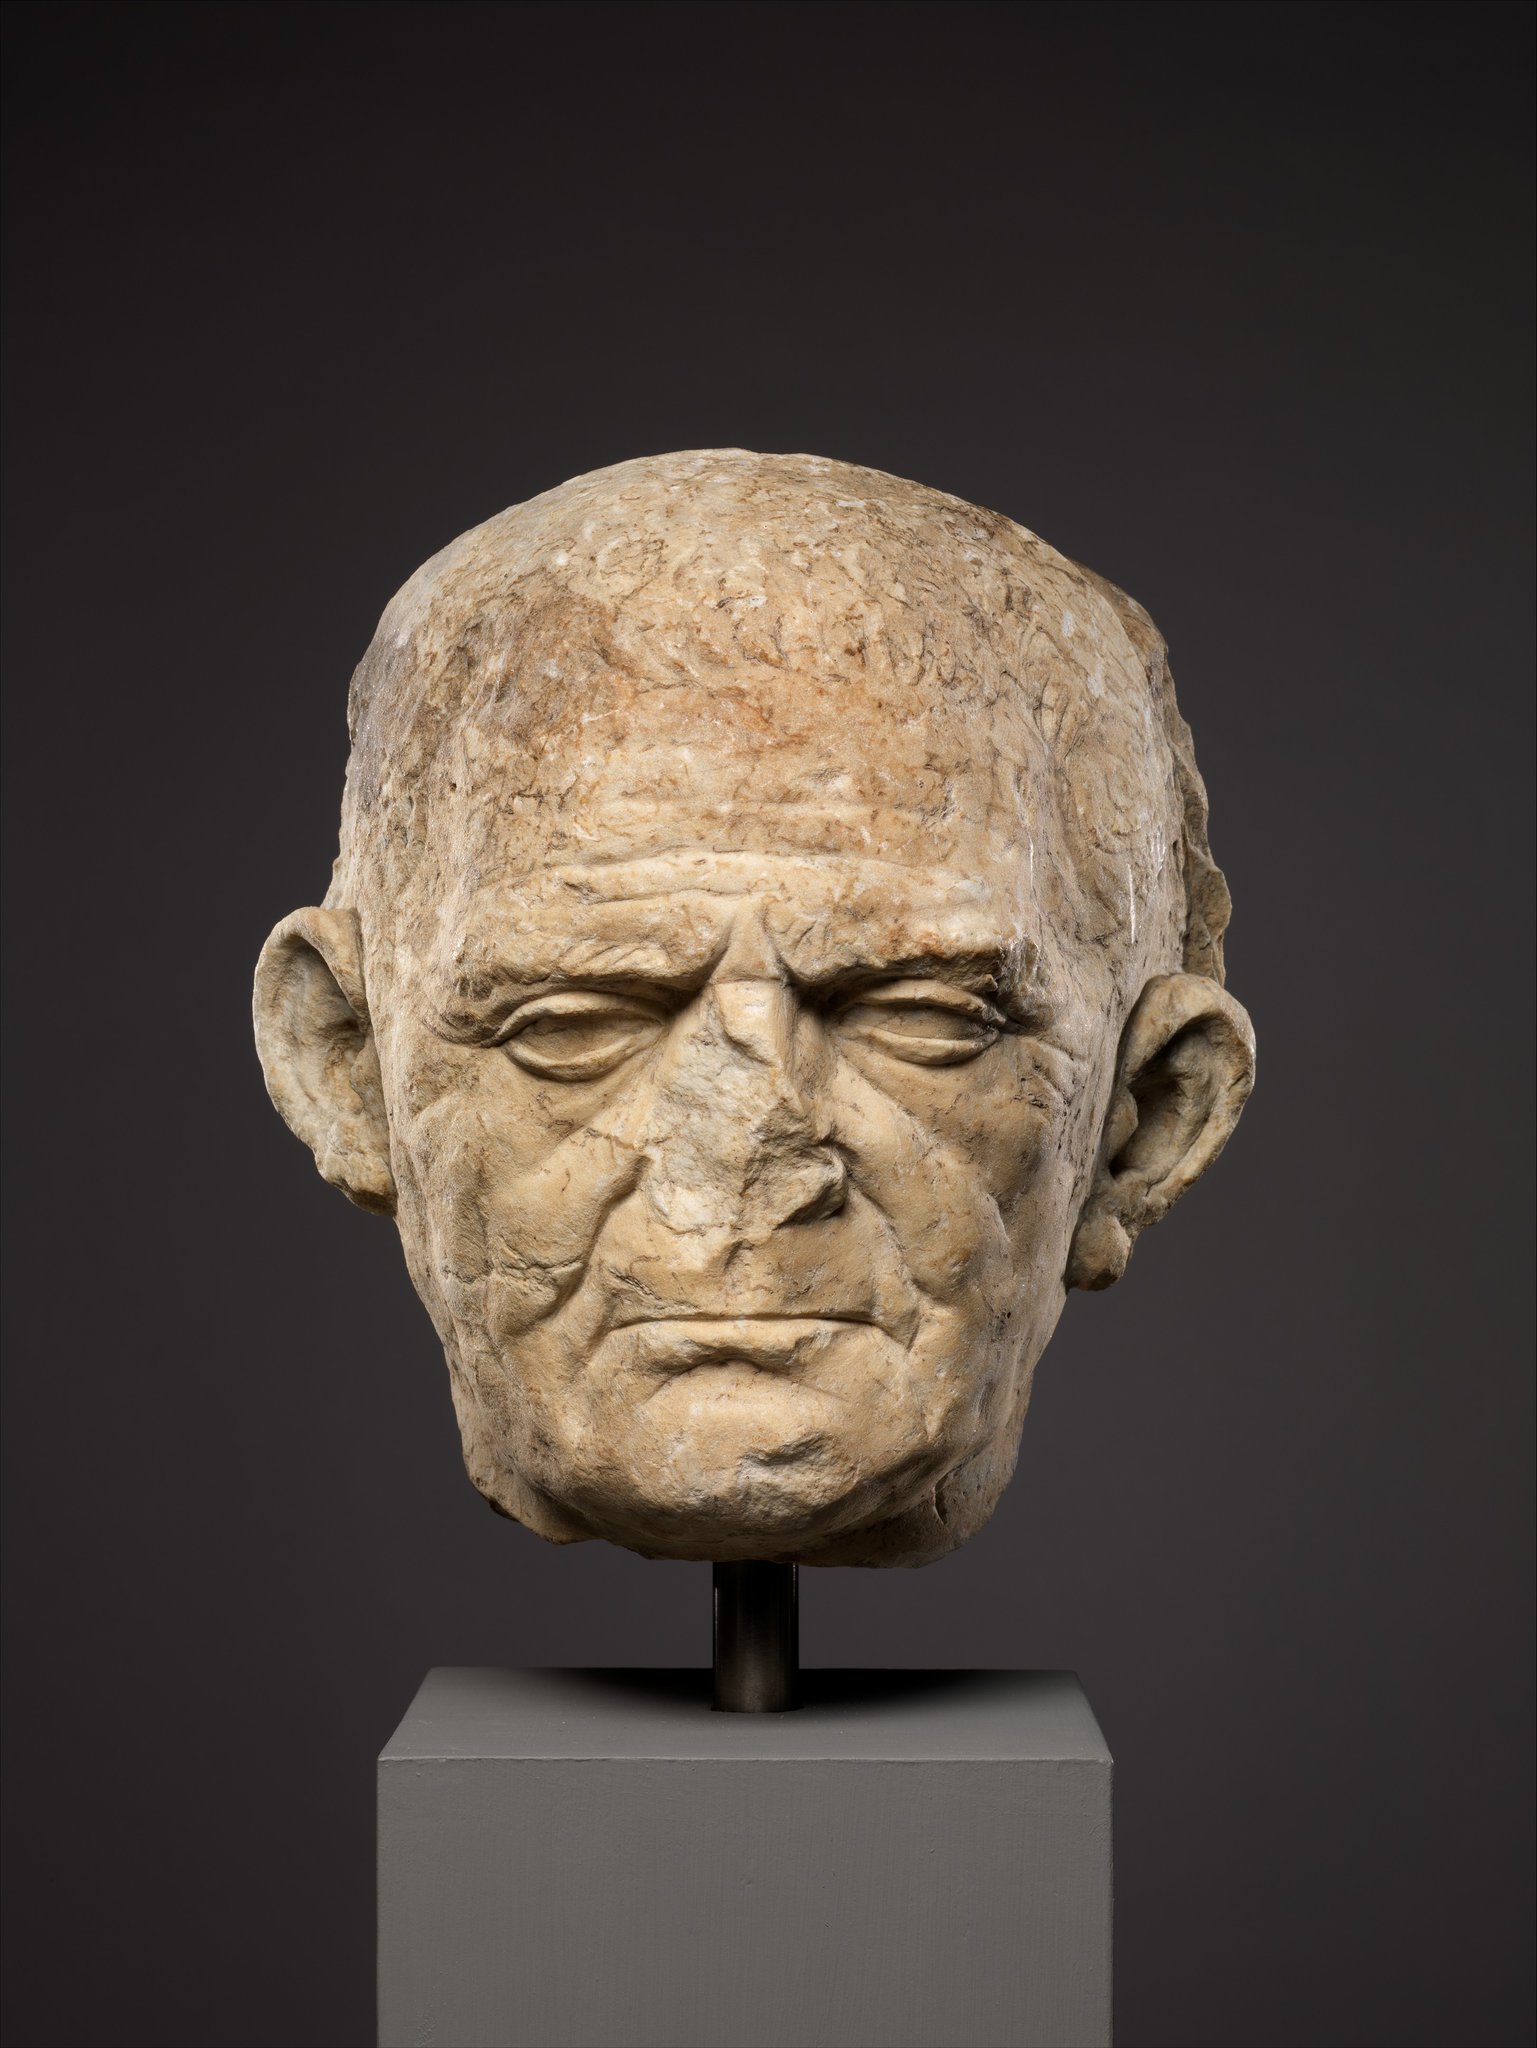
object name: portrait bust of a man from a relief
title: Marble portrait of a man from a funerary relief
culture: roman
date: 34-1 BCE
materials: marble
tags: heads,men,portraits